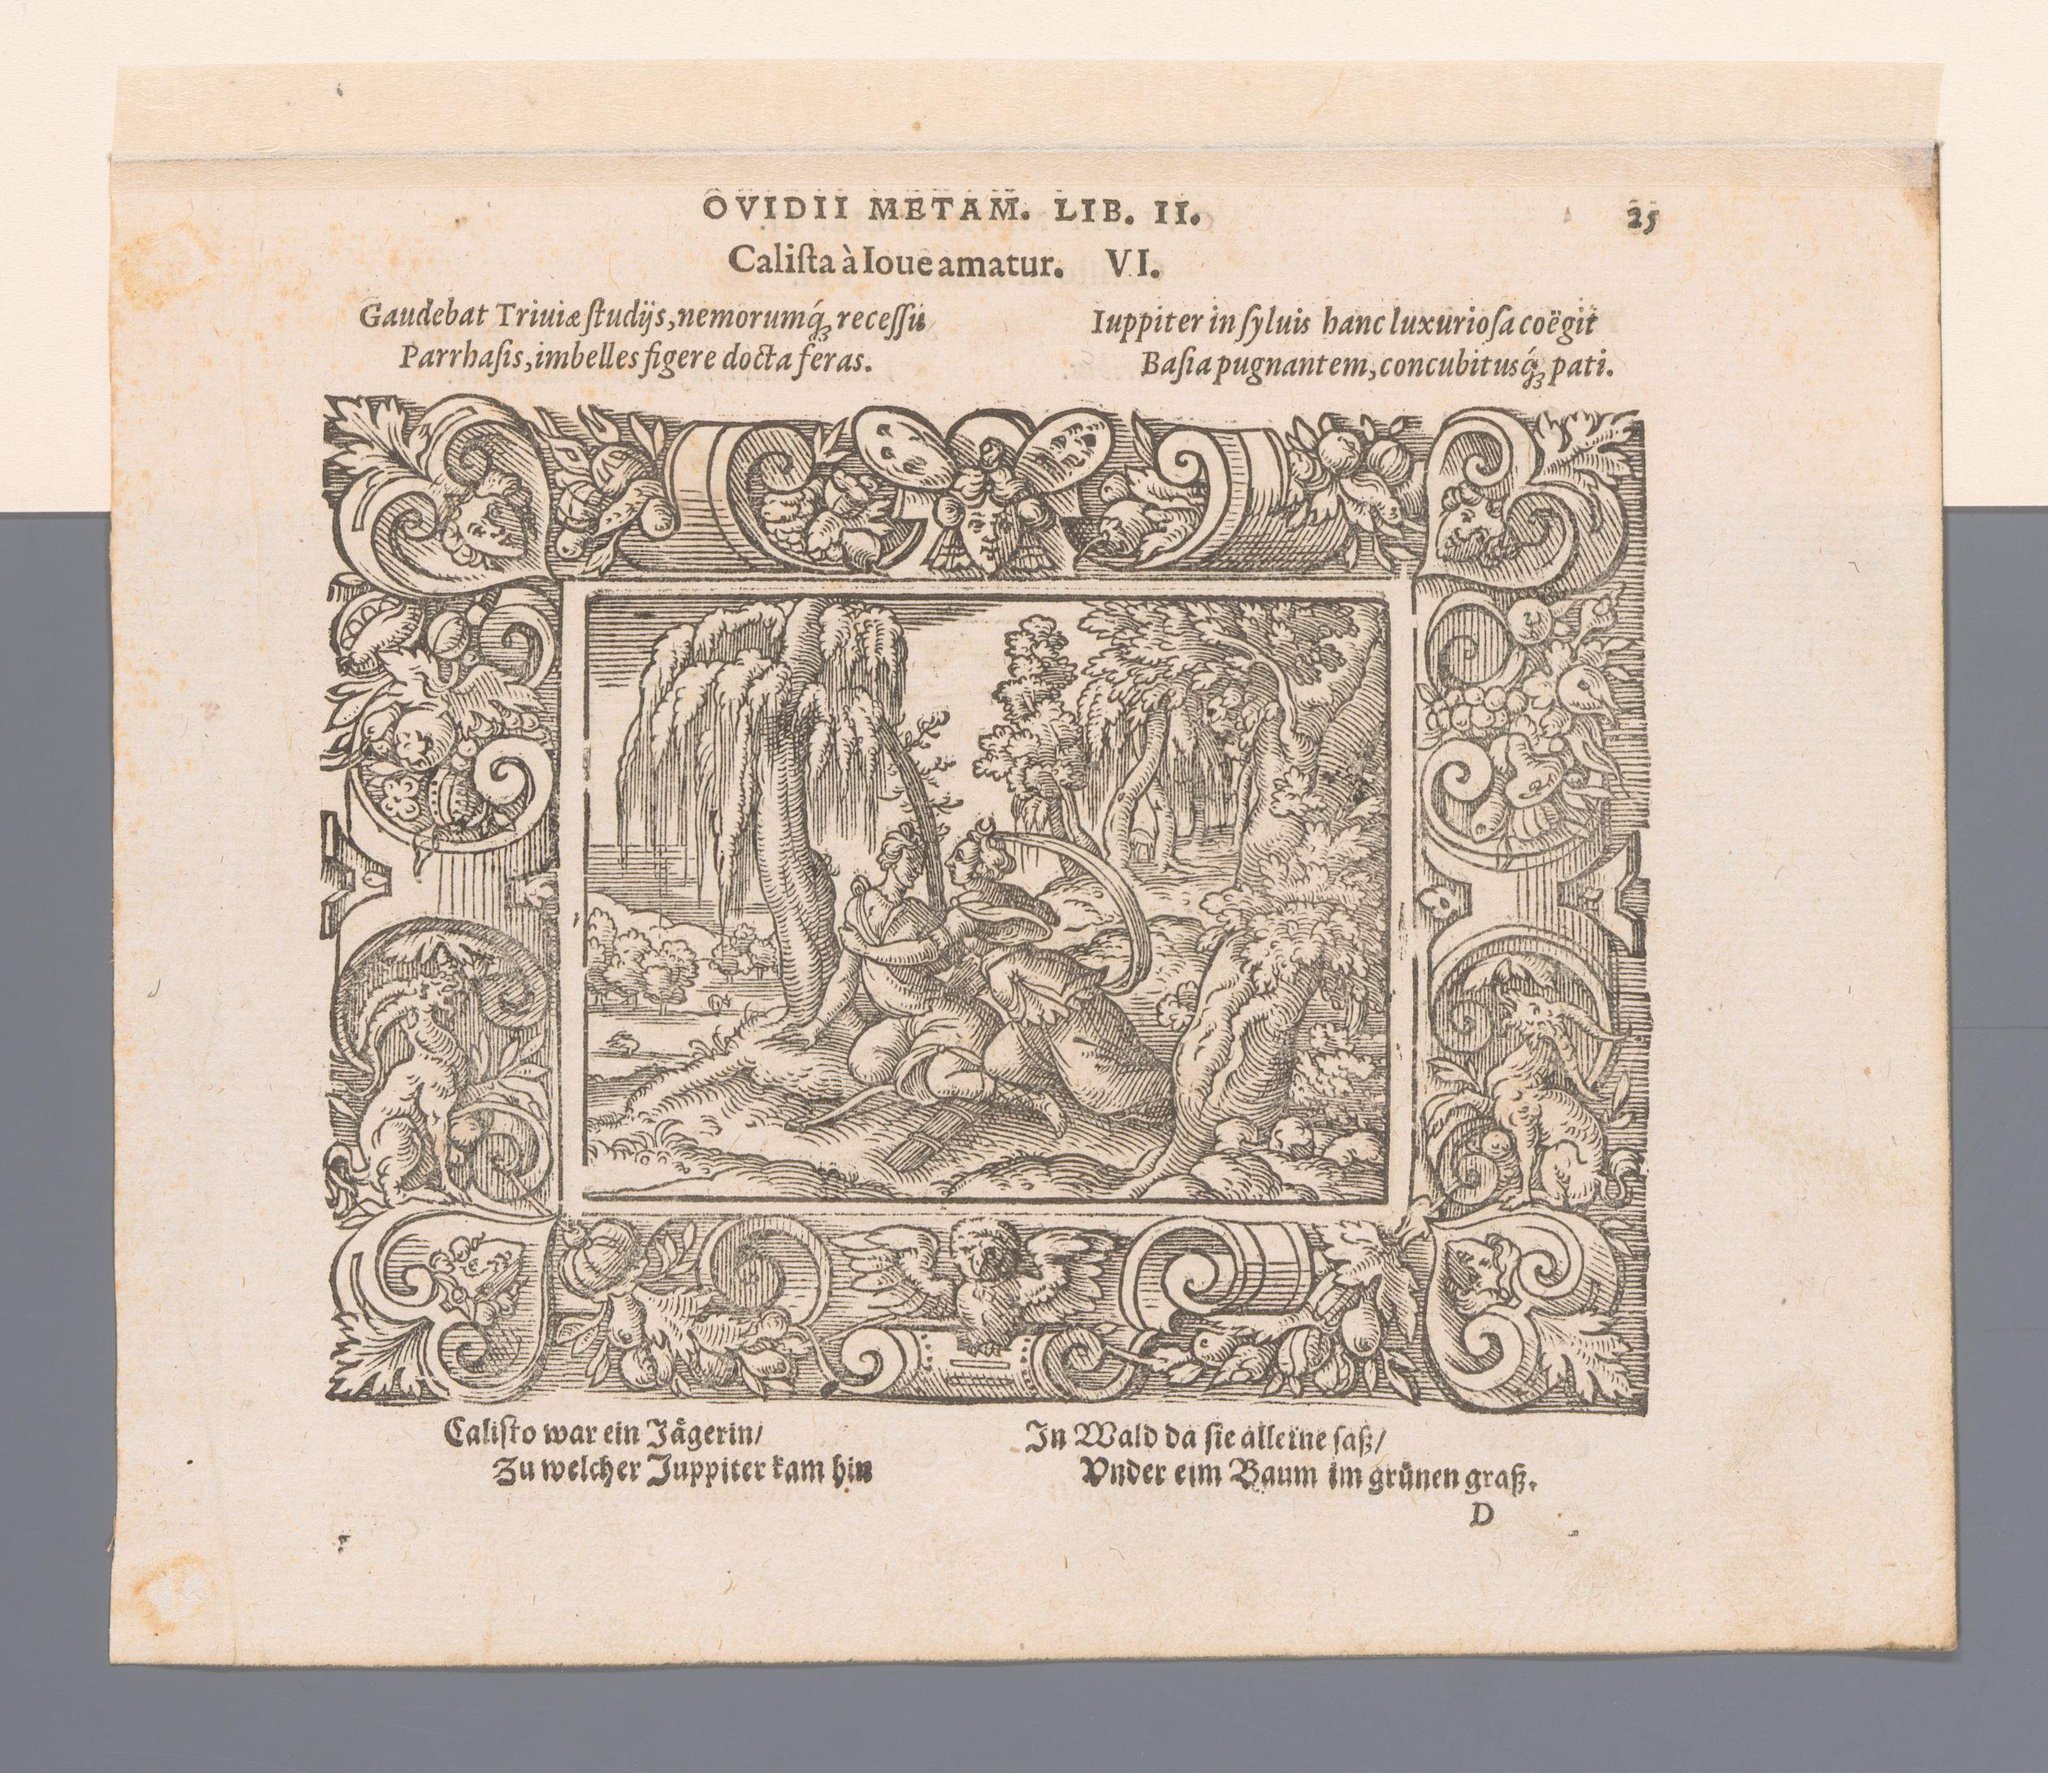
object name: book illustration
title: Jupiter en Callisto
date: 1569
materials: paper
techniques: letterpress printing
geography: frankfurt am main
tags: jupiter, in the guise of diana, and callisto, scrollwork, strapwork ~ ornament, homosexual love - cc - homosexual love between women: lesbianism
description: Illustratie bij de Metamorfosen van Ovidius, afkomstig uit de publicatie: Posthius, Johannes. Tetrasticha in Ovidii metam. Frankfurt am Main: Georg Rab en Sigmund Feyerabend en erven Weigand Han, 1569. De voorstellingen en ornamentranden van deze boekillustraties zijn van twee aparte blokken gedrukt. Beide werden afzonderlijk van elkaar ook gebruikt voor andere publicaties, en de ornamentranden werden eveneens binnen deze publicatie meerdere keren gebruikt.